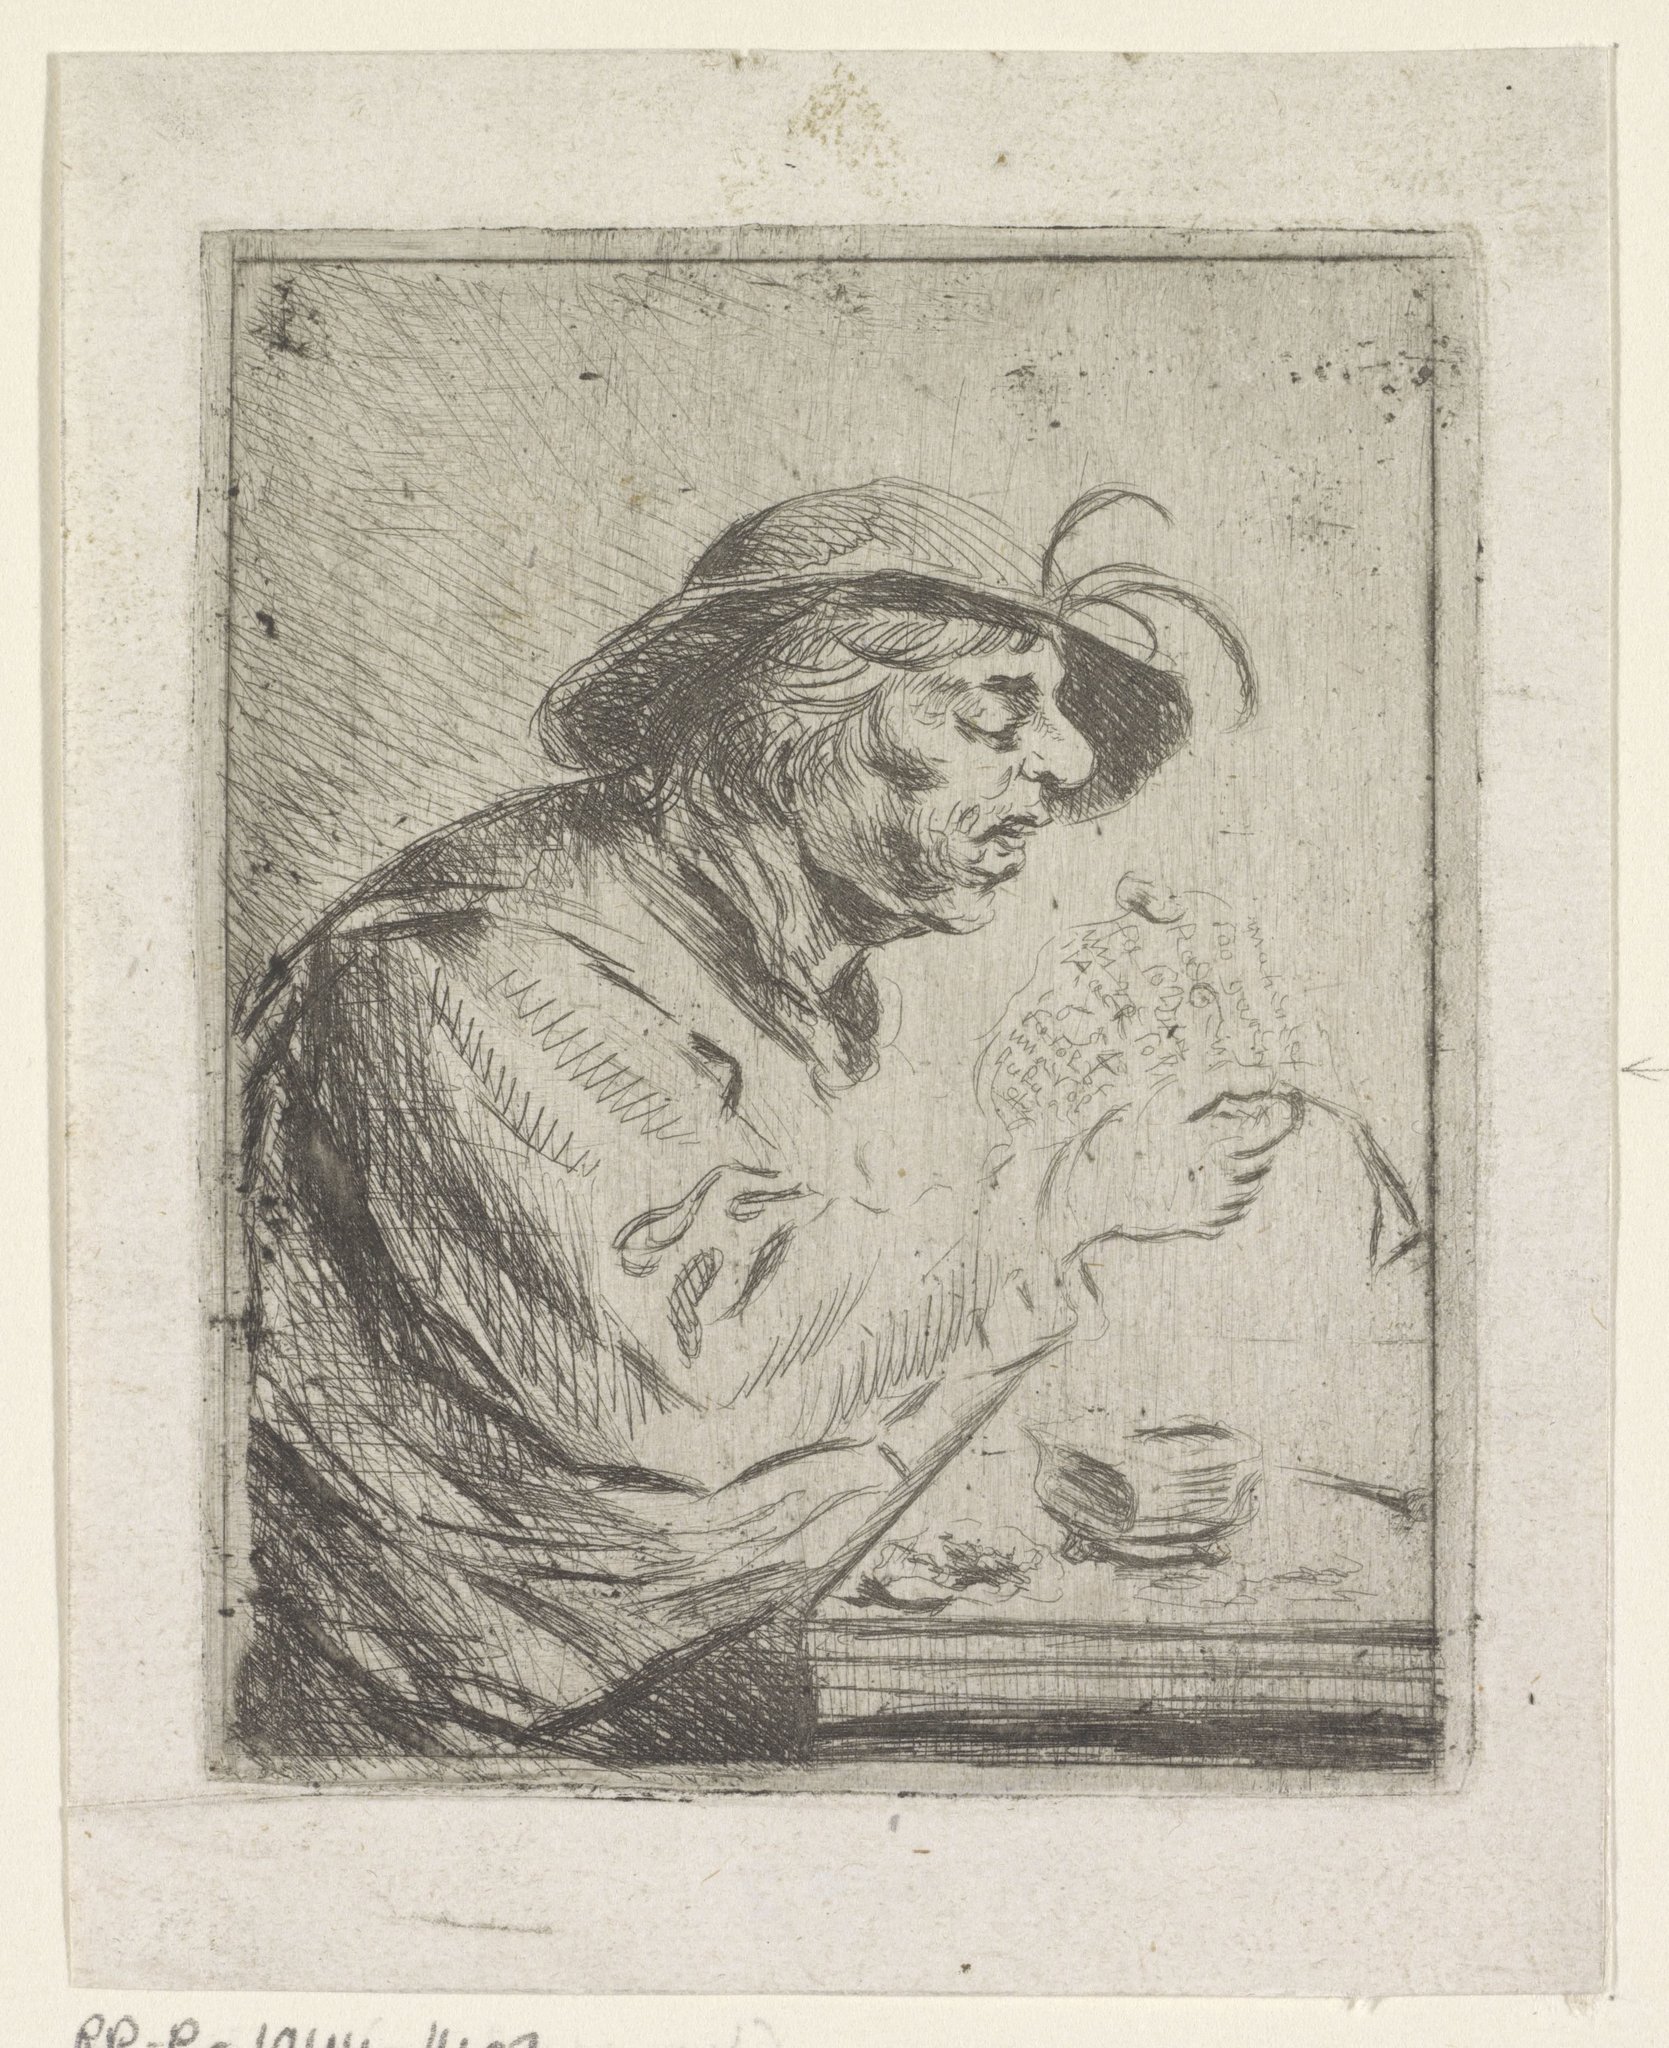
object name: print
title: Man leest brief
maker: Anonymous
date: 1654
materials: paper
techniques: etching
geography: netherlands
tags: reading, letter, envelope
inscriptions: collector's mark: Lugt 2228, collector's mark: Lugt 240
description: Een man leest een brief voor gezeten bij een tafel. Op de tafel een vuurtest.